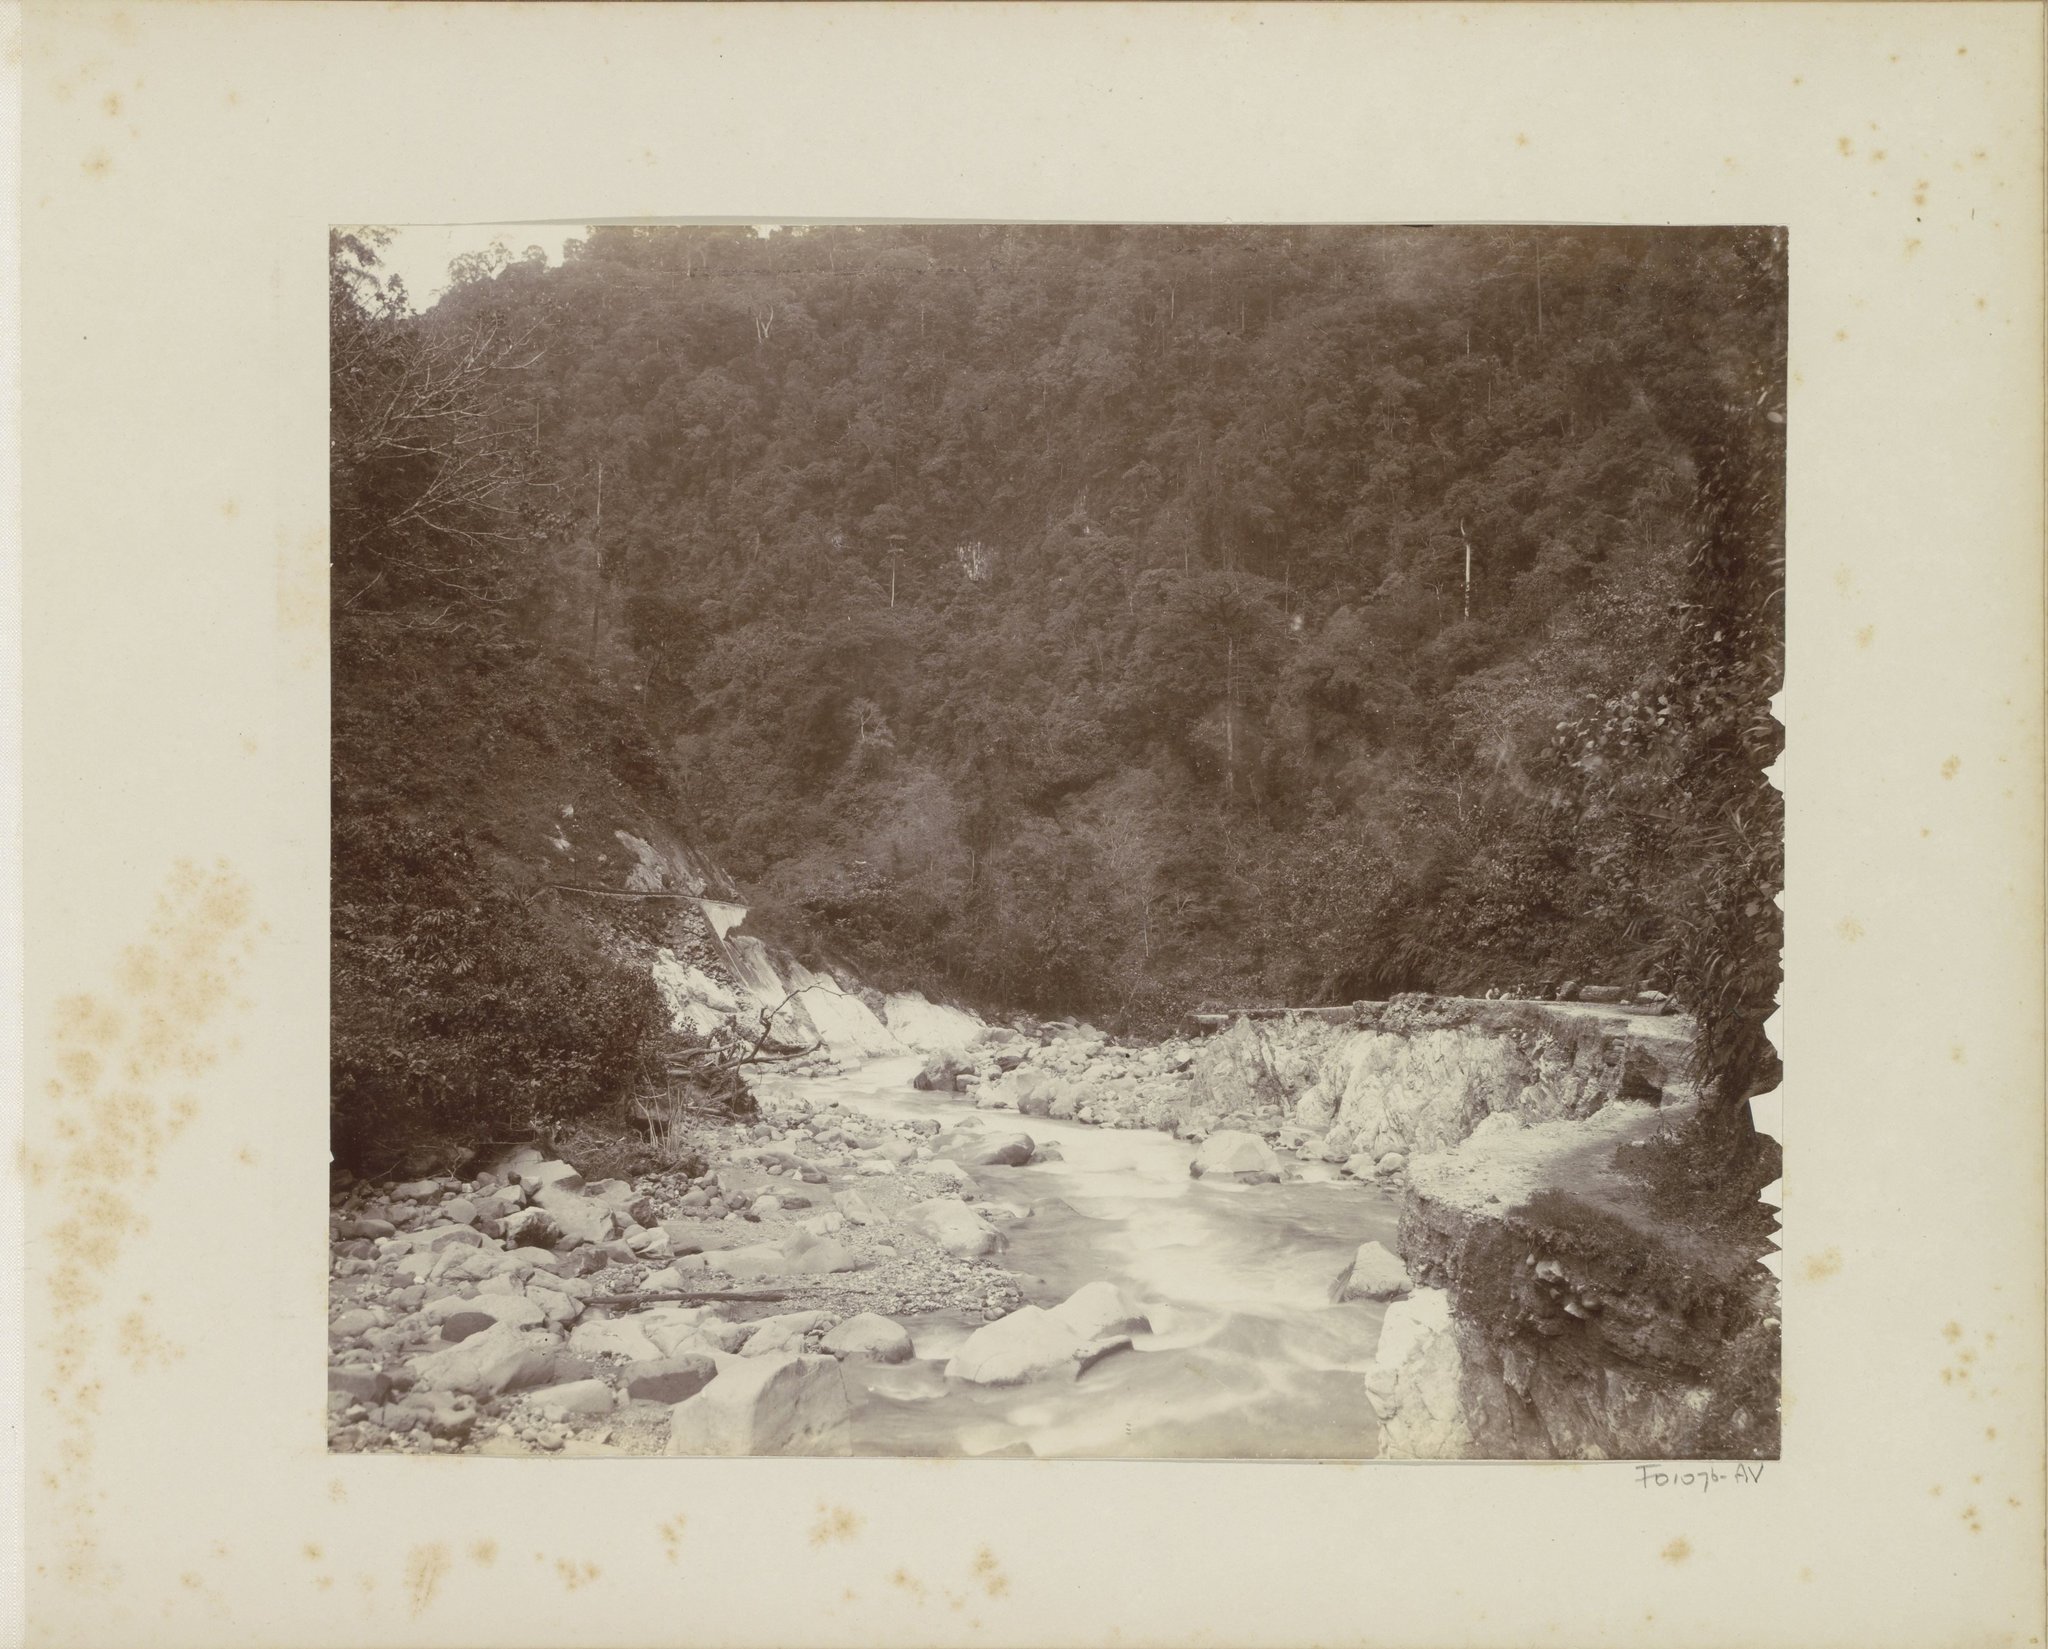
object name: album leaf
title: Beek met een weg erlangs en arbeiders in Nederlands-Indië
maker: Anonymous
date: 1880-1910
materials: cardboard, photographic support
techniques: albumen print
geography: dutch east indies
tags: brook, railway, train, dutch east indies, the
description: Onderdeel van Album met foto's van spoorwegen in Nederlands-Indië en prentbriefkaarten.